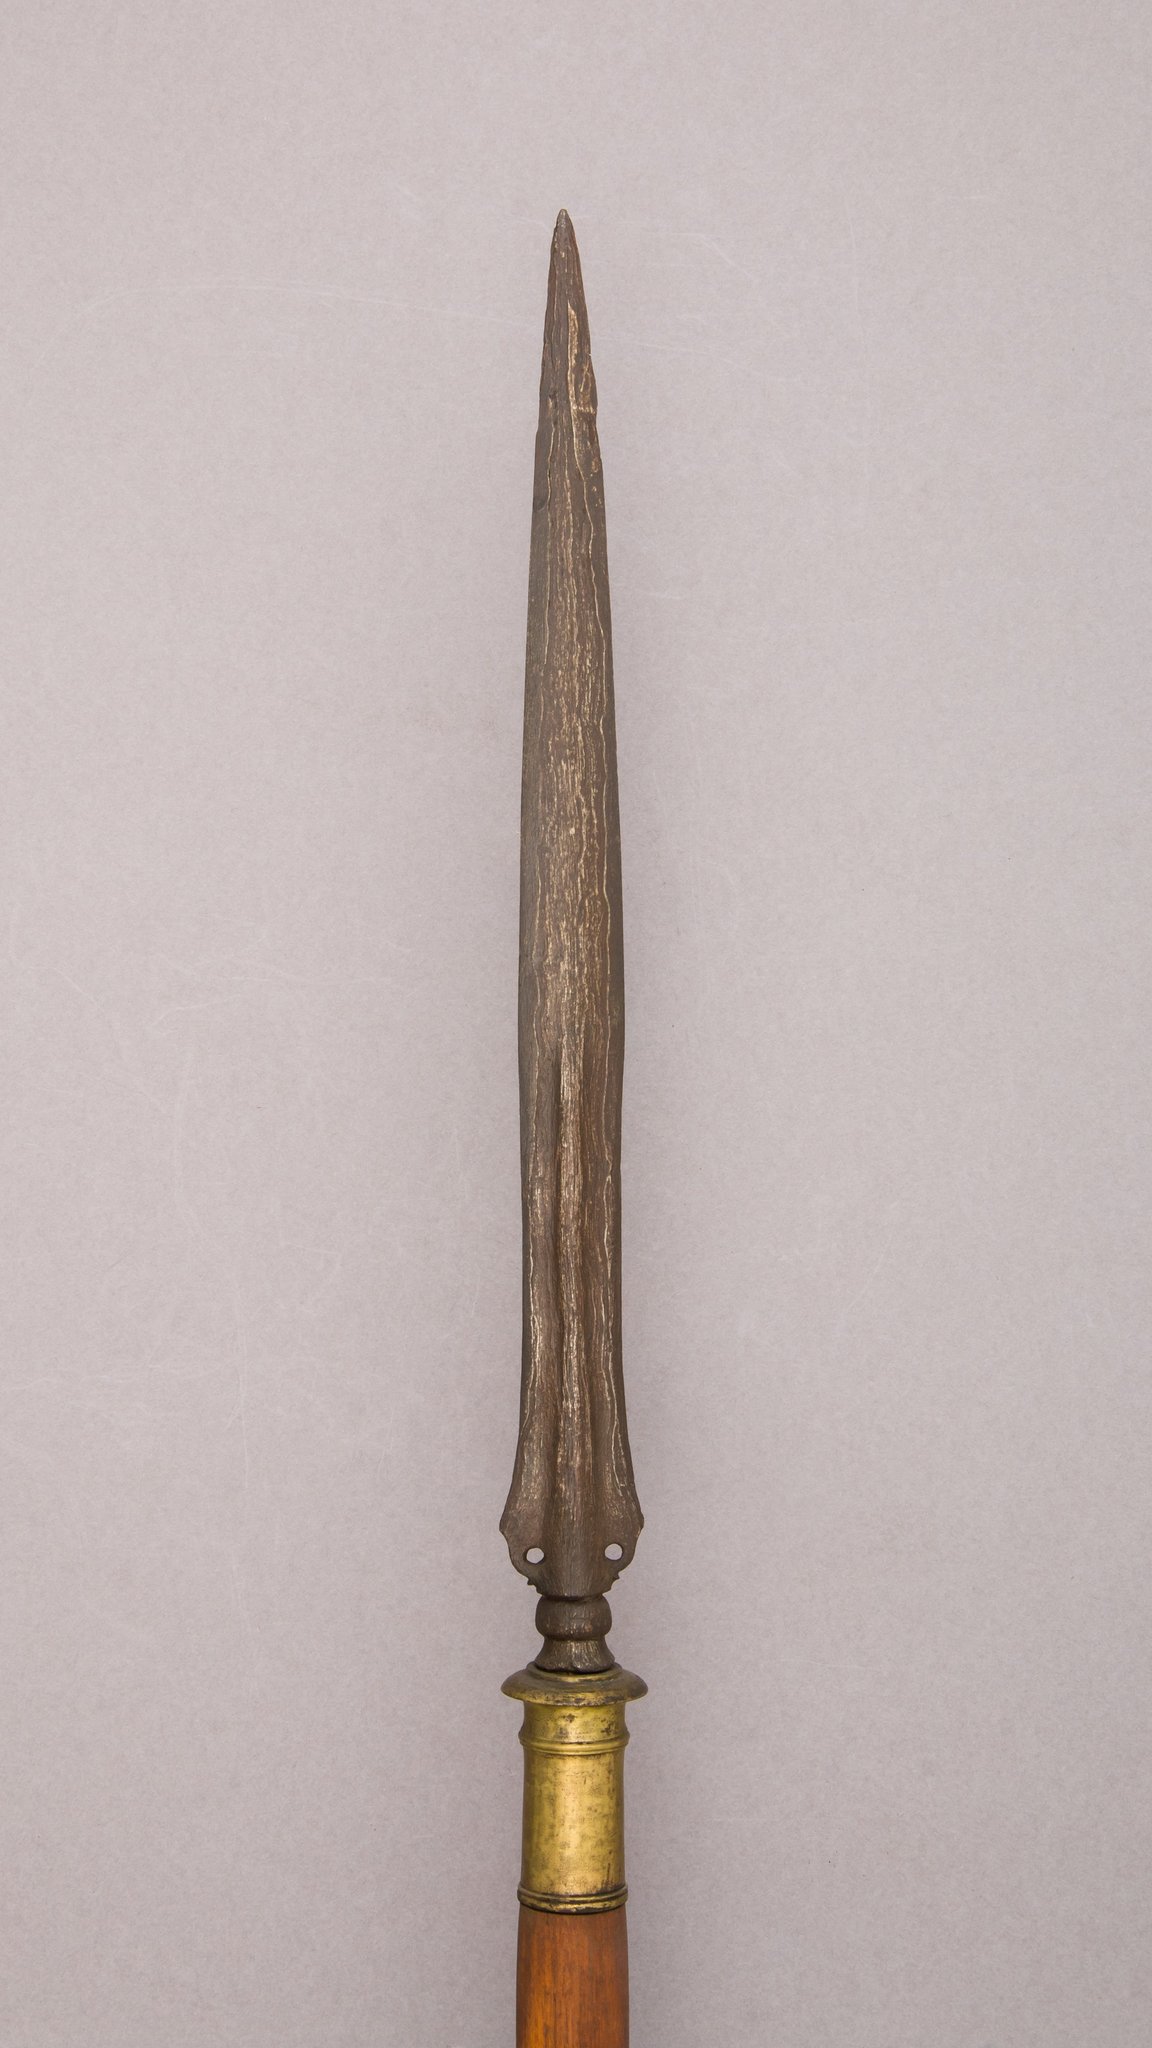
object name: spear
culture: malayan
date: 1701-1900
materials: brass, iron, wood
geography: malay archipelago